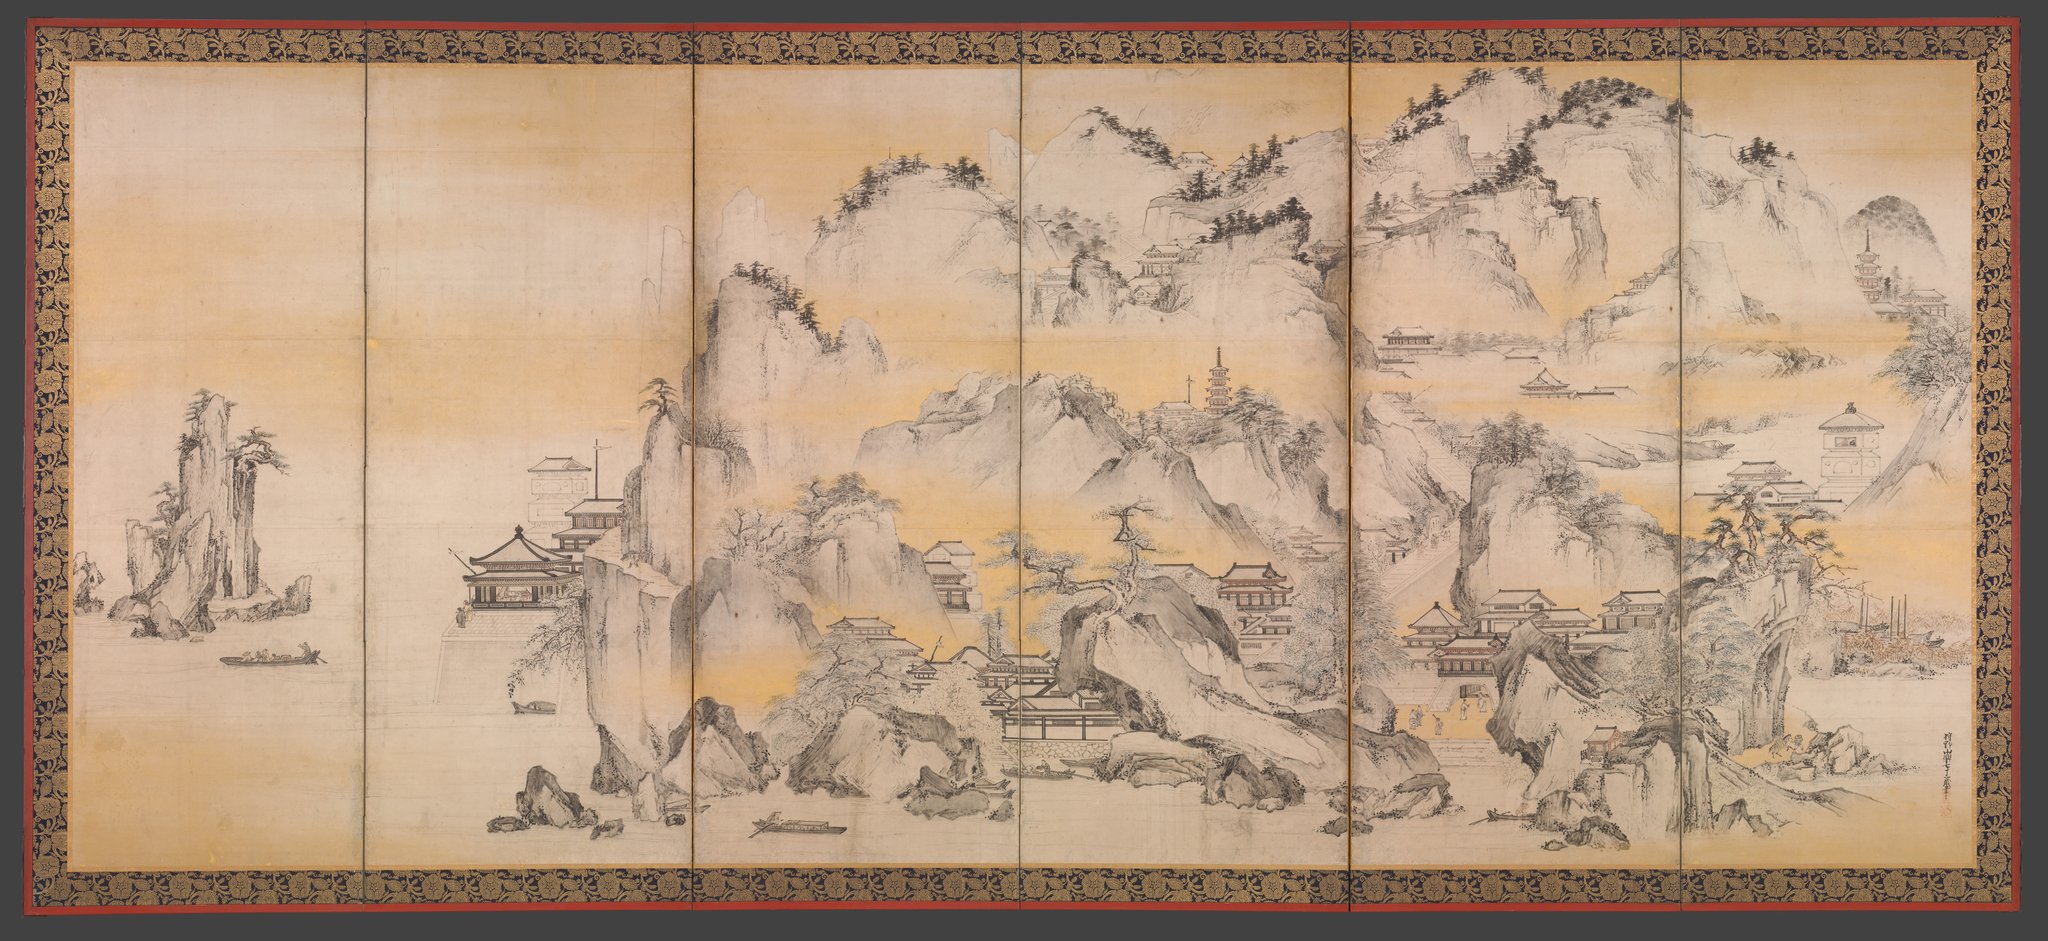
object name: screen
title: Jinshan Island and West Lake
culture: japanese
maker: kano sanraku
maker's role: artist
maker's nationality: japanese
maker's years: 1559-1635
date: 1630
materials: gold, ink, panel, paper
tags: mountains,landscapes